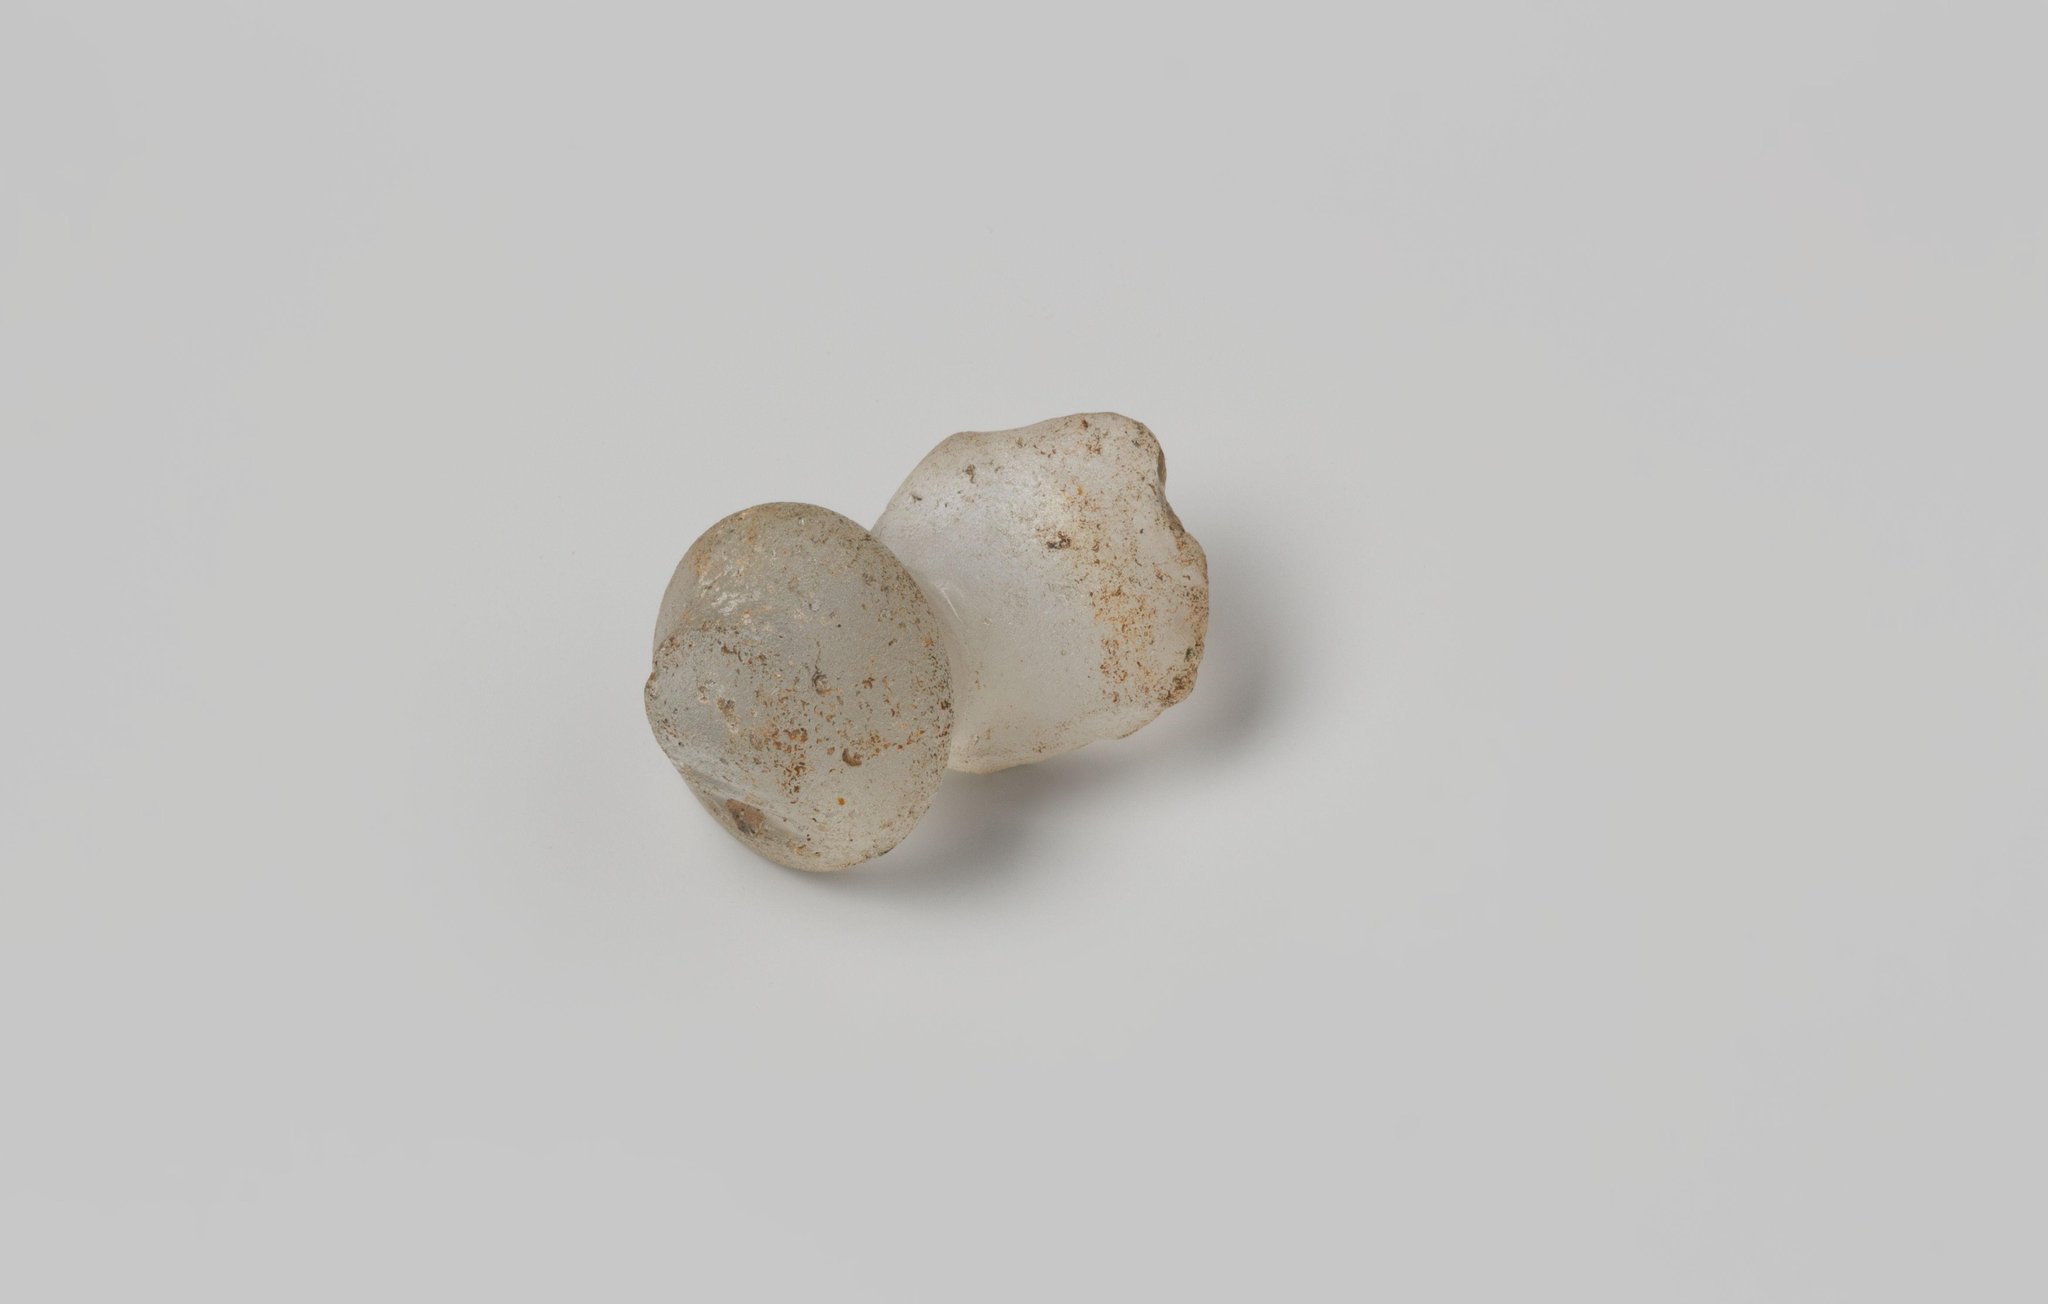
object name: flute glass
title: Fragment kom van een fluitglas uit het wrak van de Oost-Indiëvaarder Hollandia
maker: Anonymous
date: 1700-1743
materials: glass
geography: netherlands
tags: verenigde oostindische compagnie, hollandia (schip), annet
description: Glass, stem glass, bowl; fragment of base, circular, with everted side, plain, on short straight shaft over an angular knop, stem broken off.